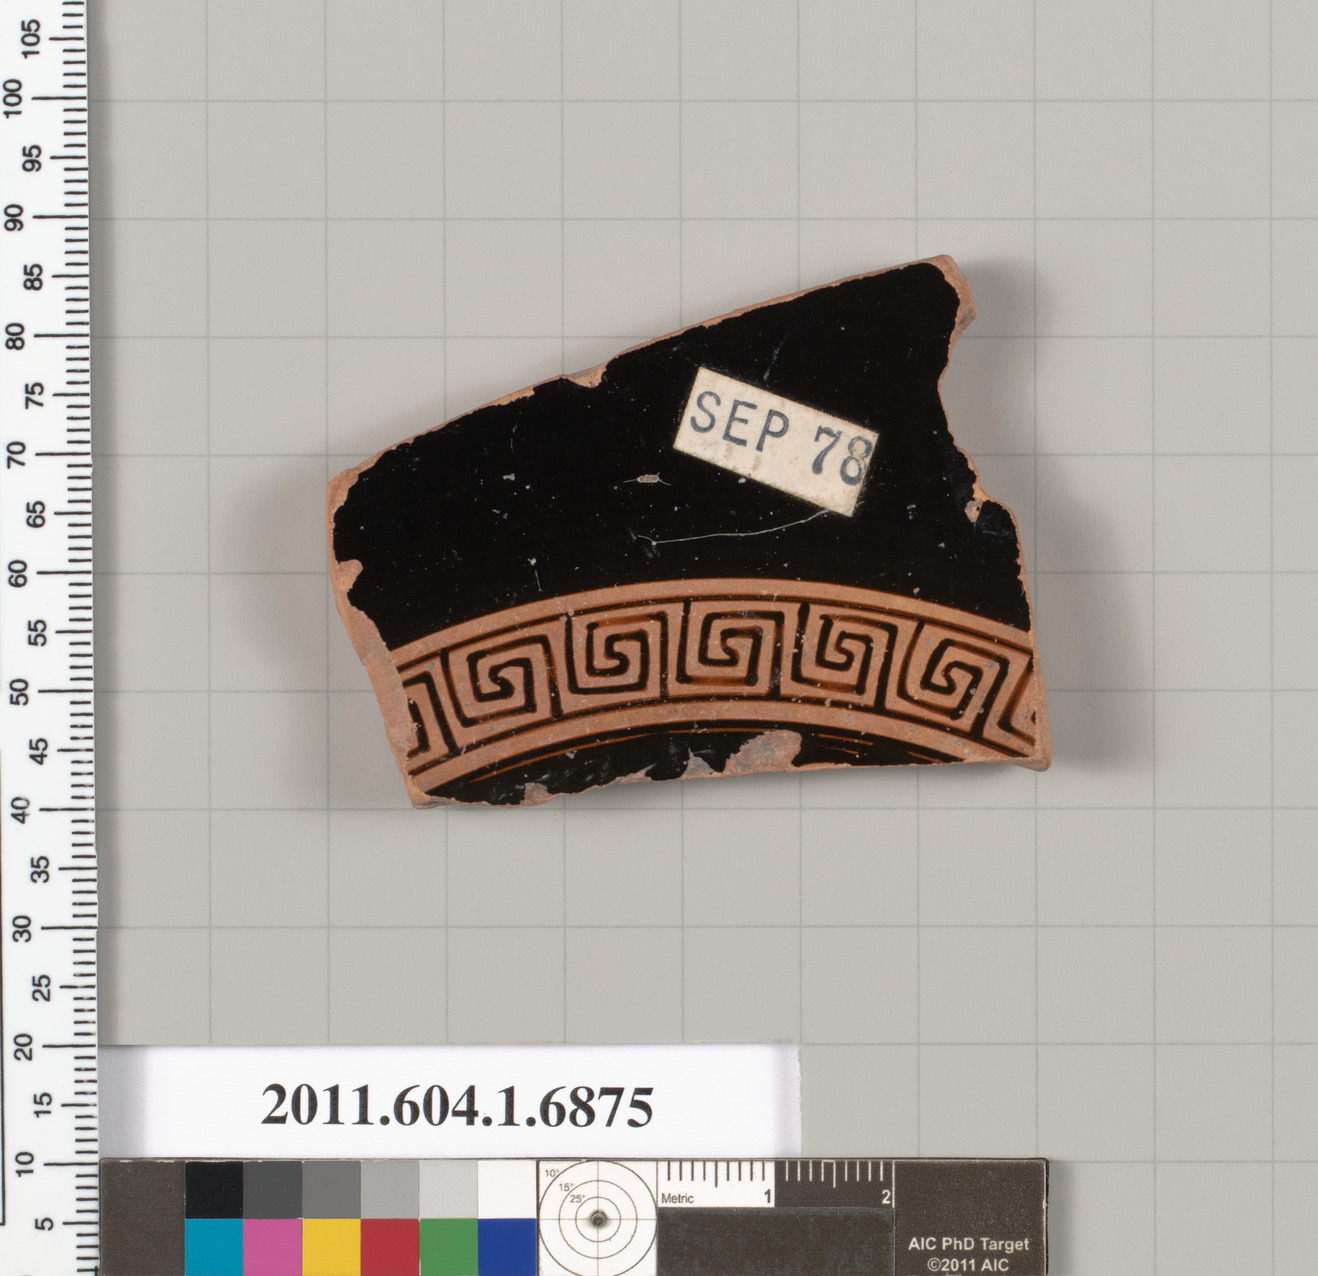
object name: kylix fragment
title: Terracotta fragment of a kylix (drinking cup)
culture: greek, attic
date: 490-470 BCE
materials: terracotta